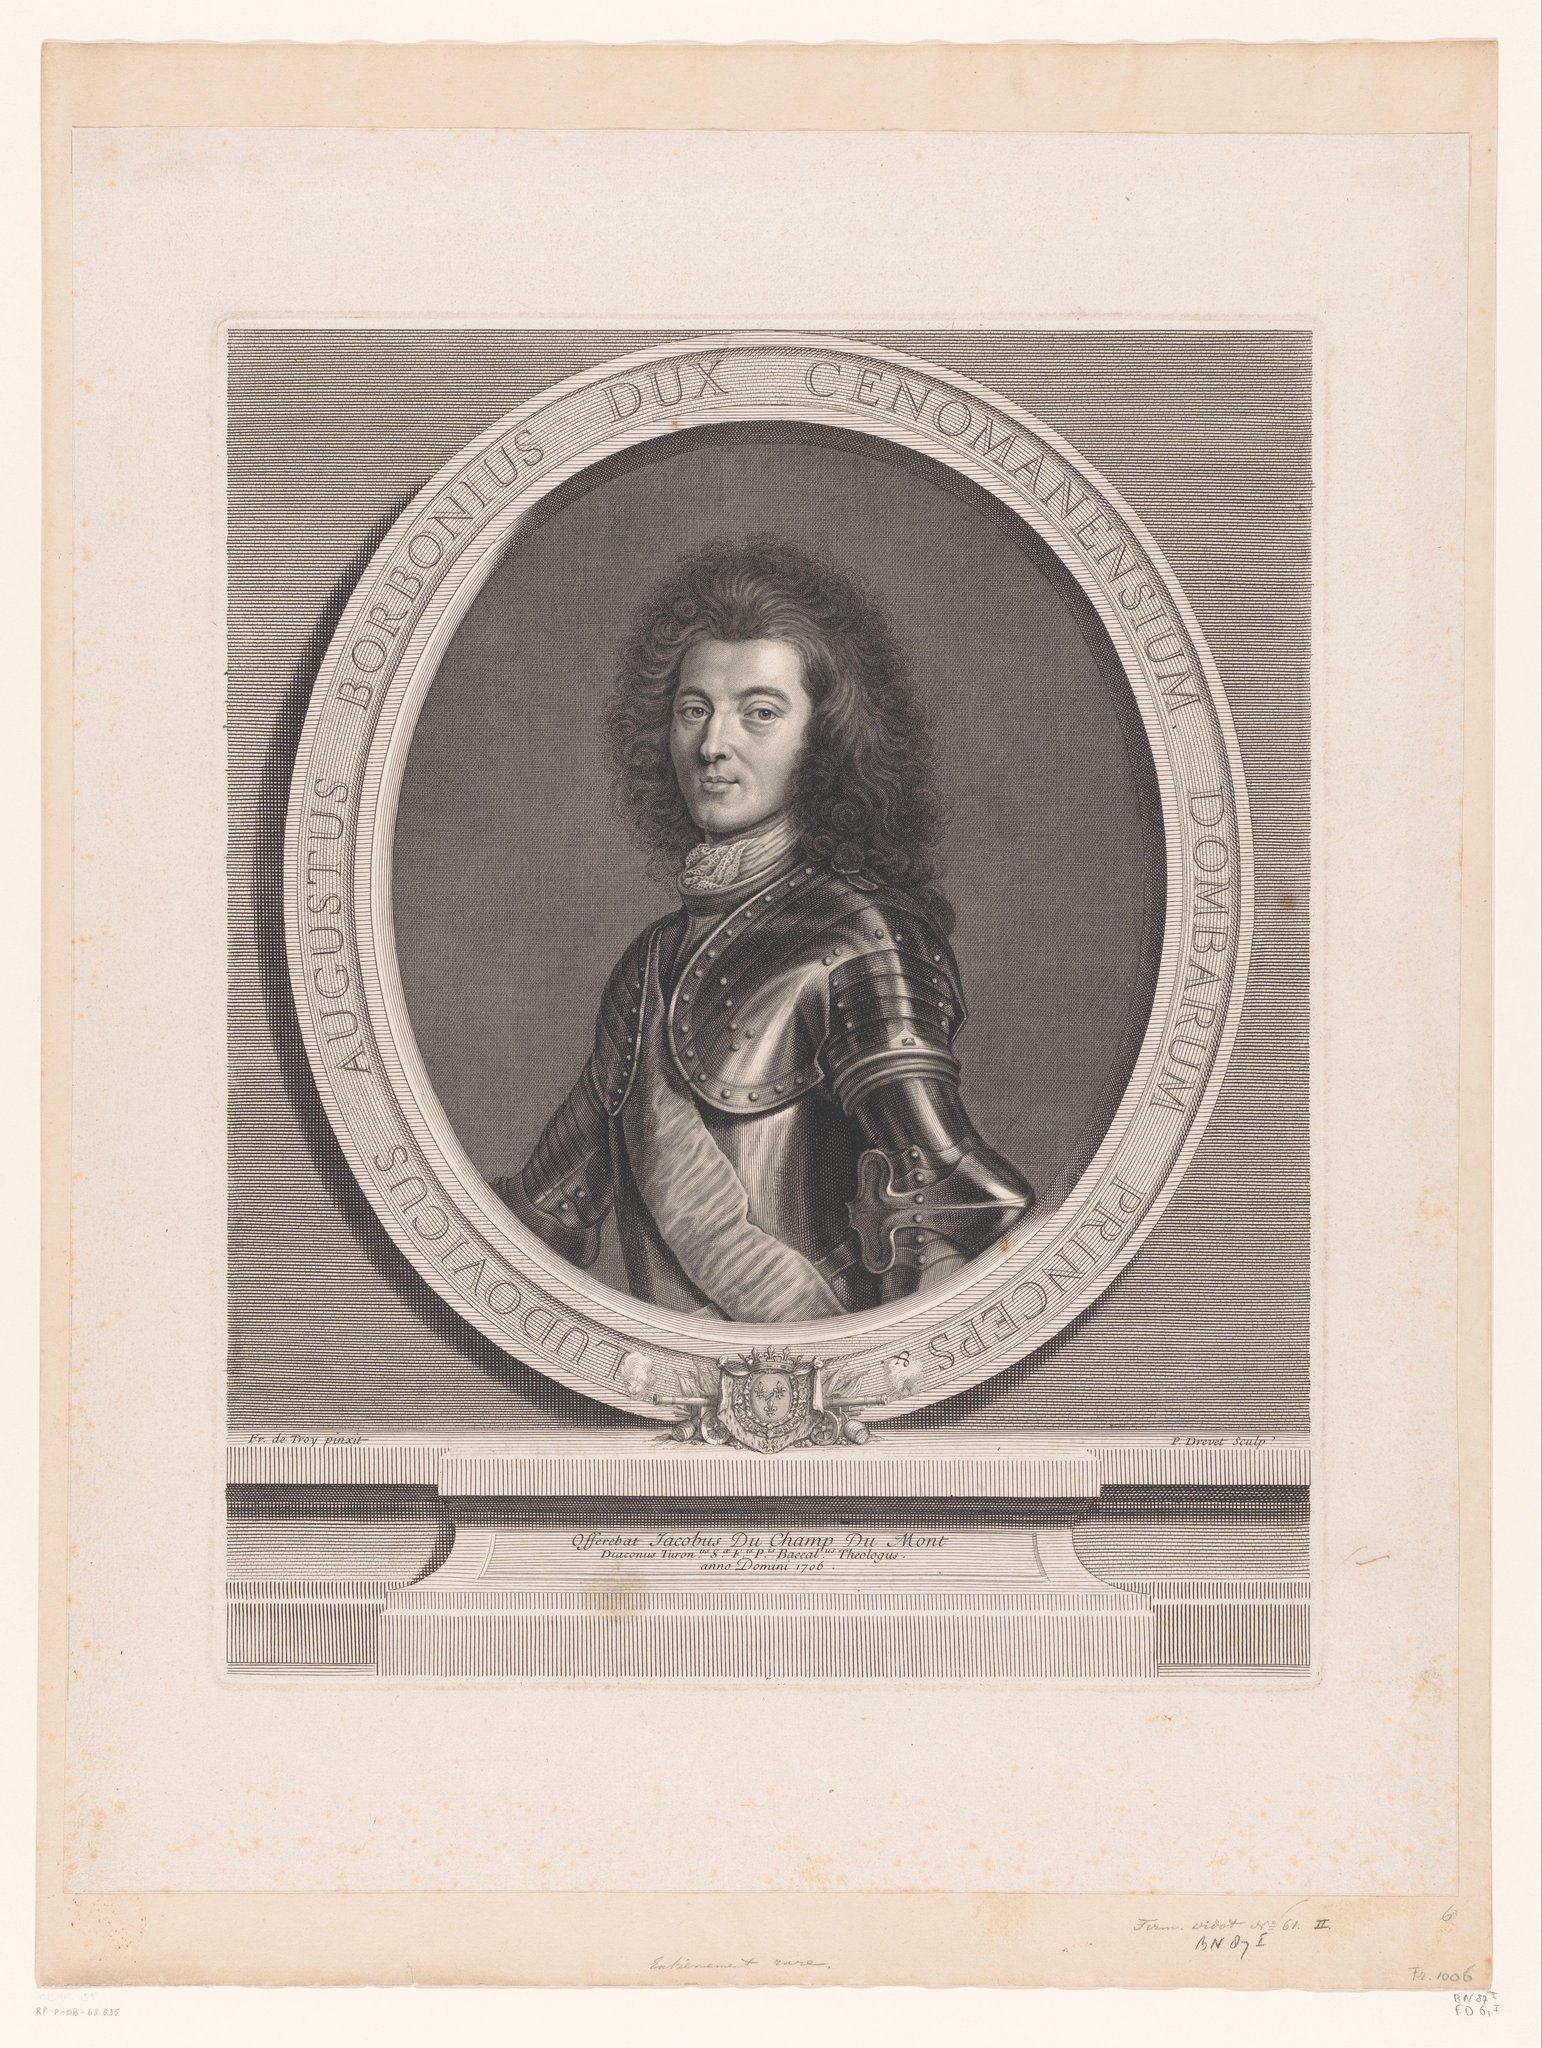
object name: print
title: Portret van Lodewijk August van Bourbon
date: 1706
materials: paper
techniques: engraving, etching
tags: louis auguste (duke of maine), historical persons, armorial bearing, heraldry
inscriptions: collector's mark: Lugt 240